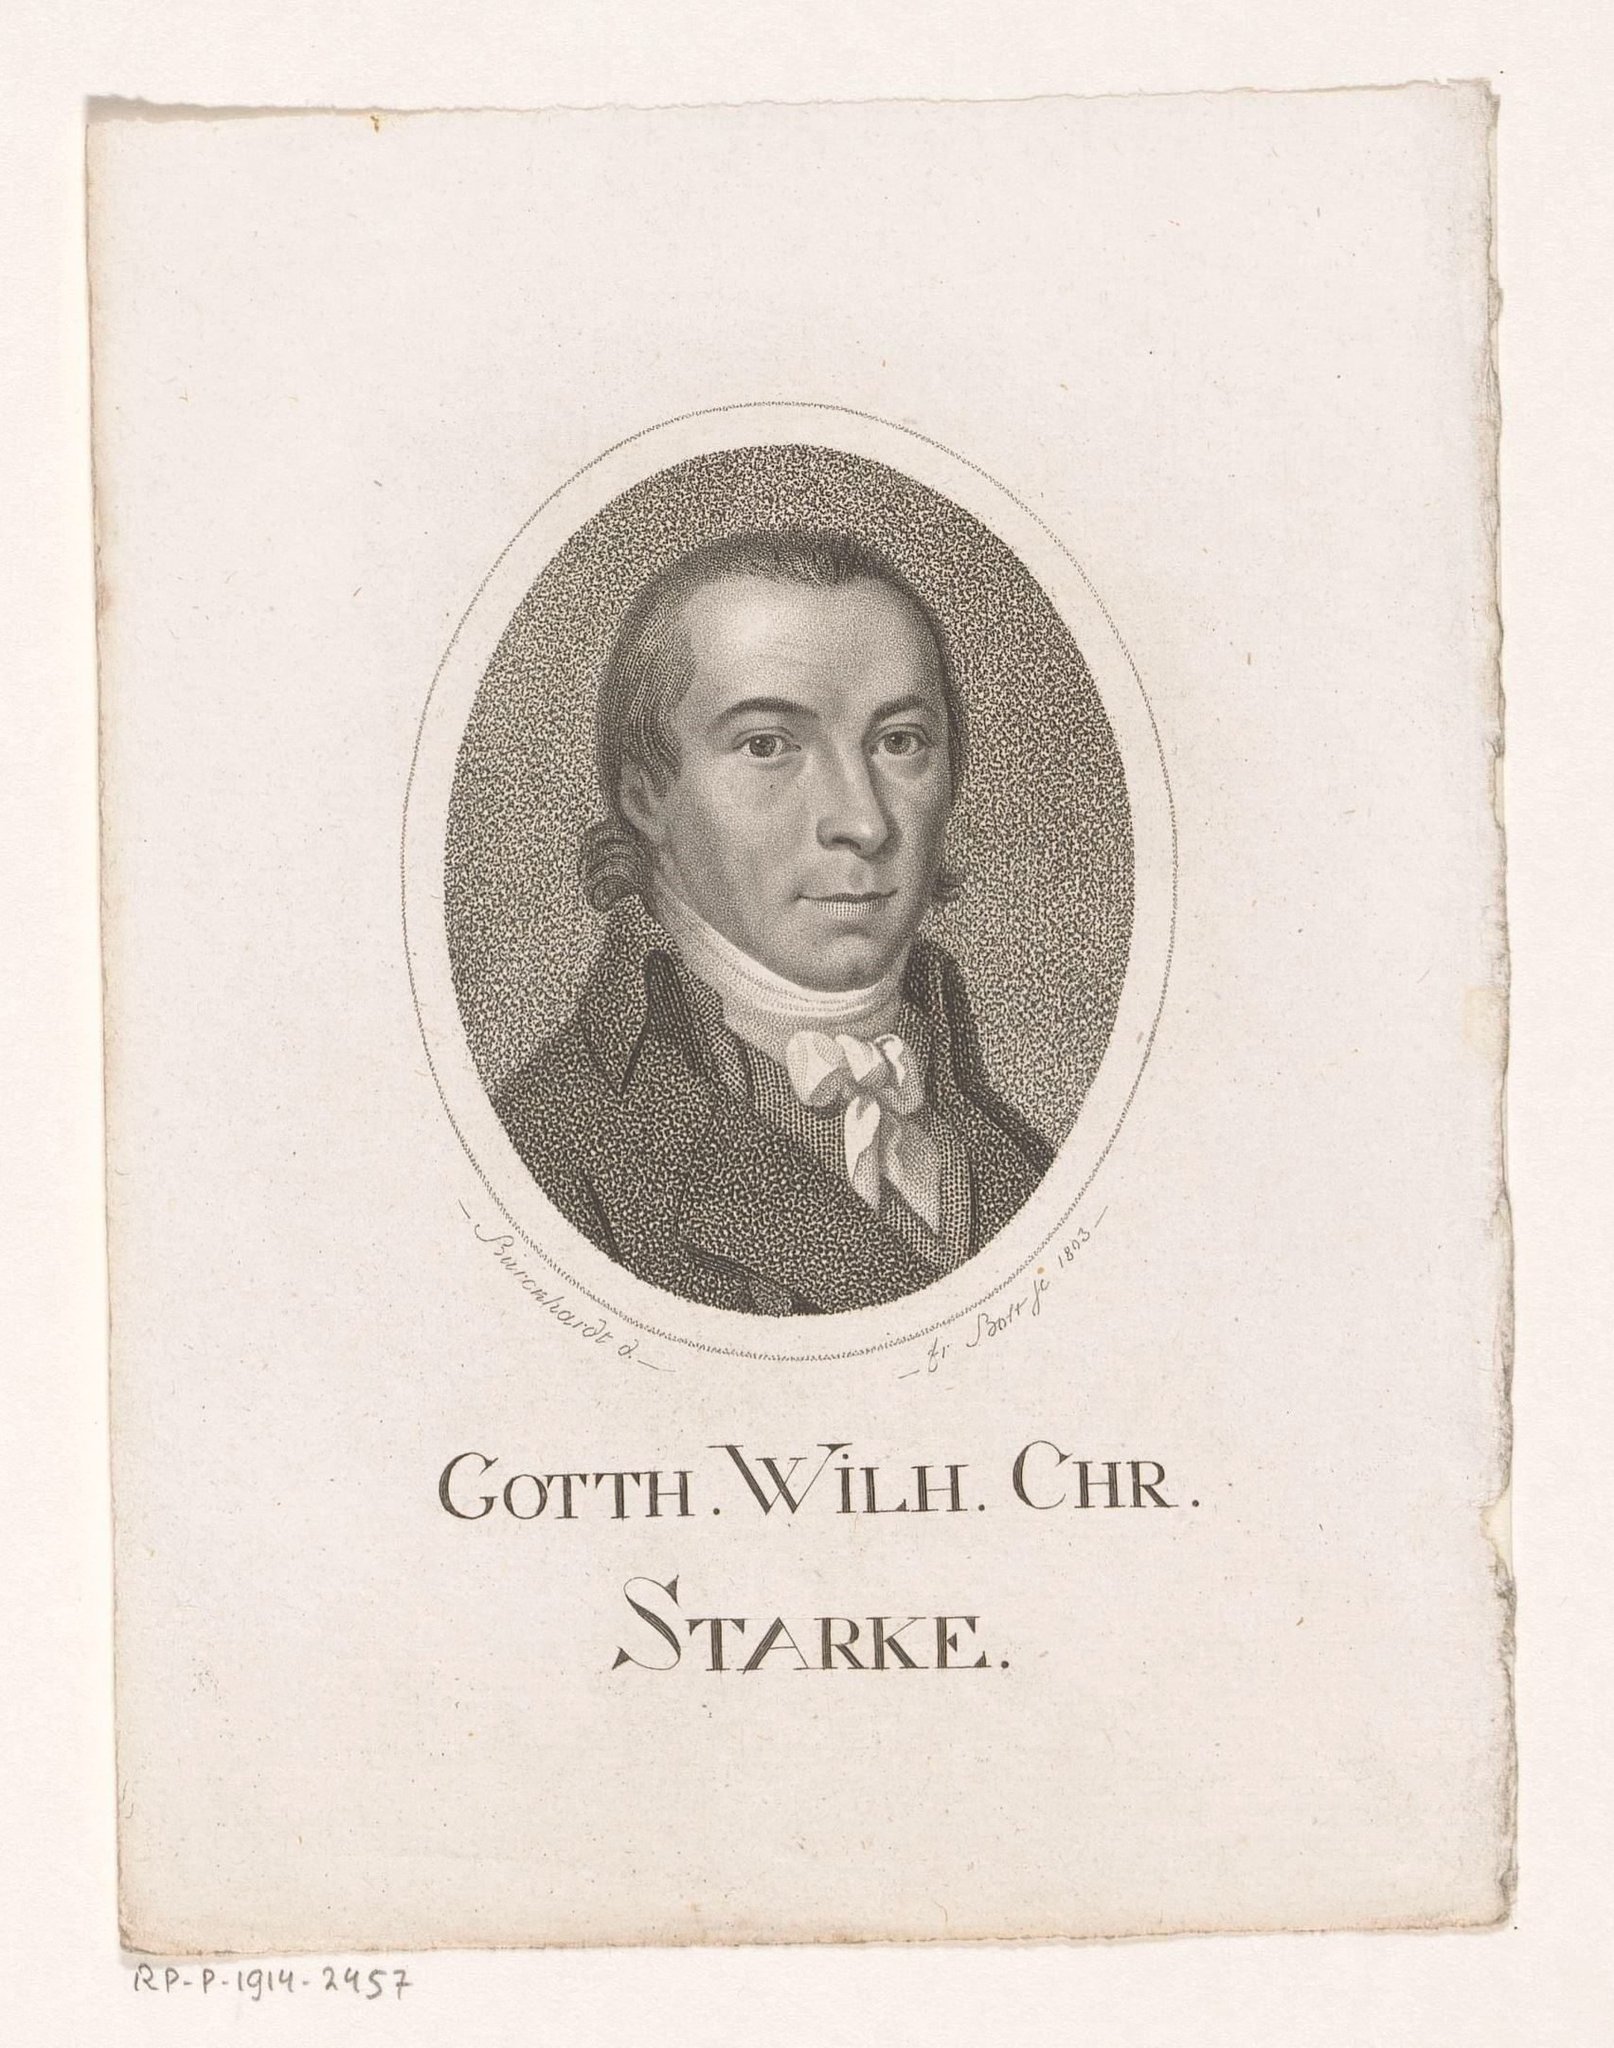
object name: print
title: Portret van Gotthelf Wilhelm Christoph Starke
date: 1803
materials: paper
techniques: stippling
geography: berlin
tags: historical persons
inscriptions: collector's mark: Lugt 2228